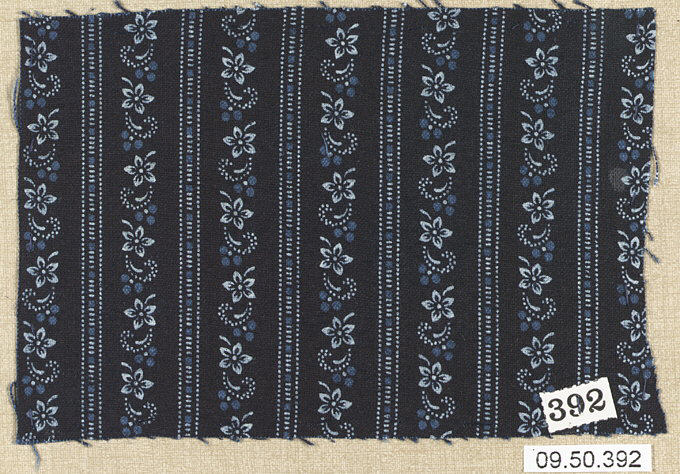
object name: piece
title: Piece (one of 116)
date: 1801-1900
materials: cotton